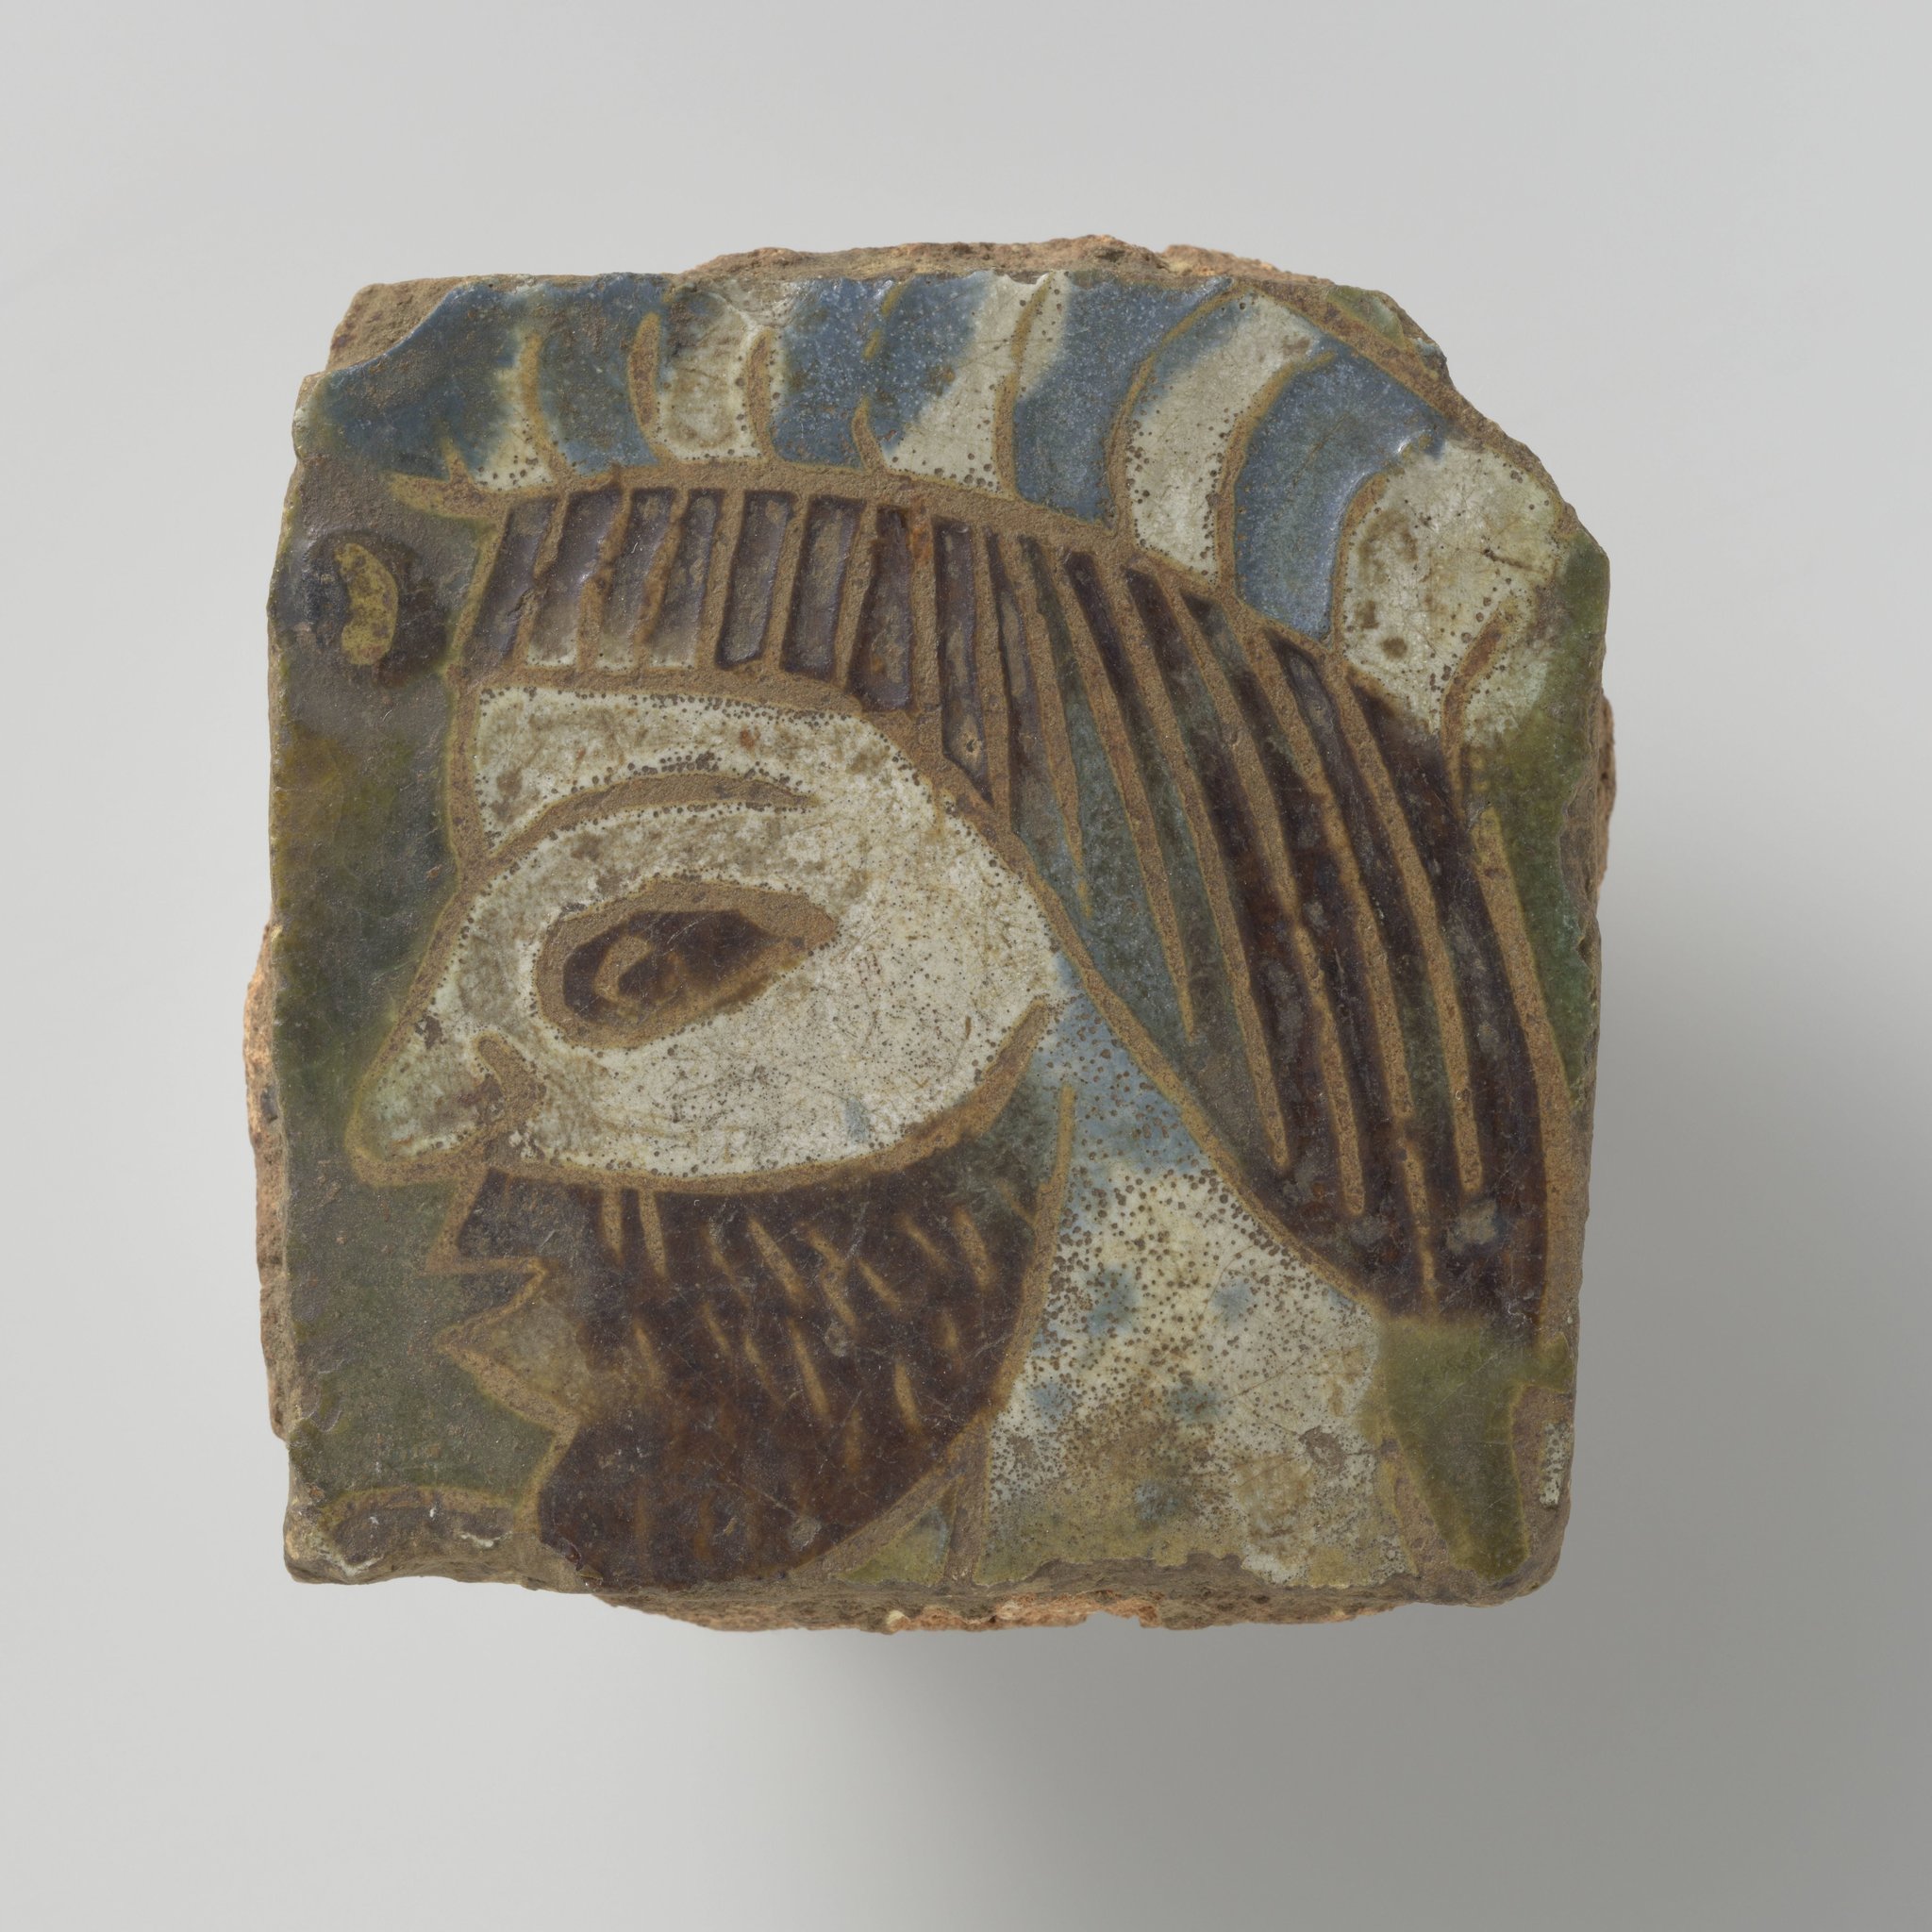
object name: tile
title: tegel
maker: Anonymous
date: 1500-1525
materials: earthenware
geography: sevilla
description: Vierkante tegel. Afbeelding van een mannenkop in profiel naar links, met lange haren en lange baard. De voorstelling is in de kleilaag uitgehold en daarna met glazuur gevuld.